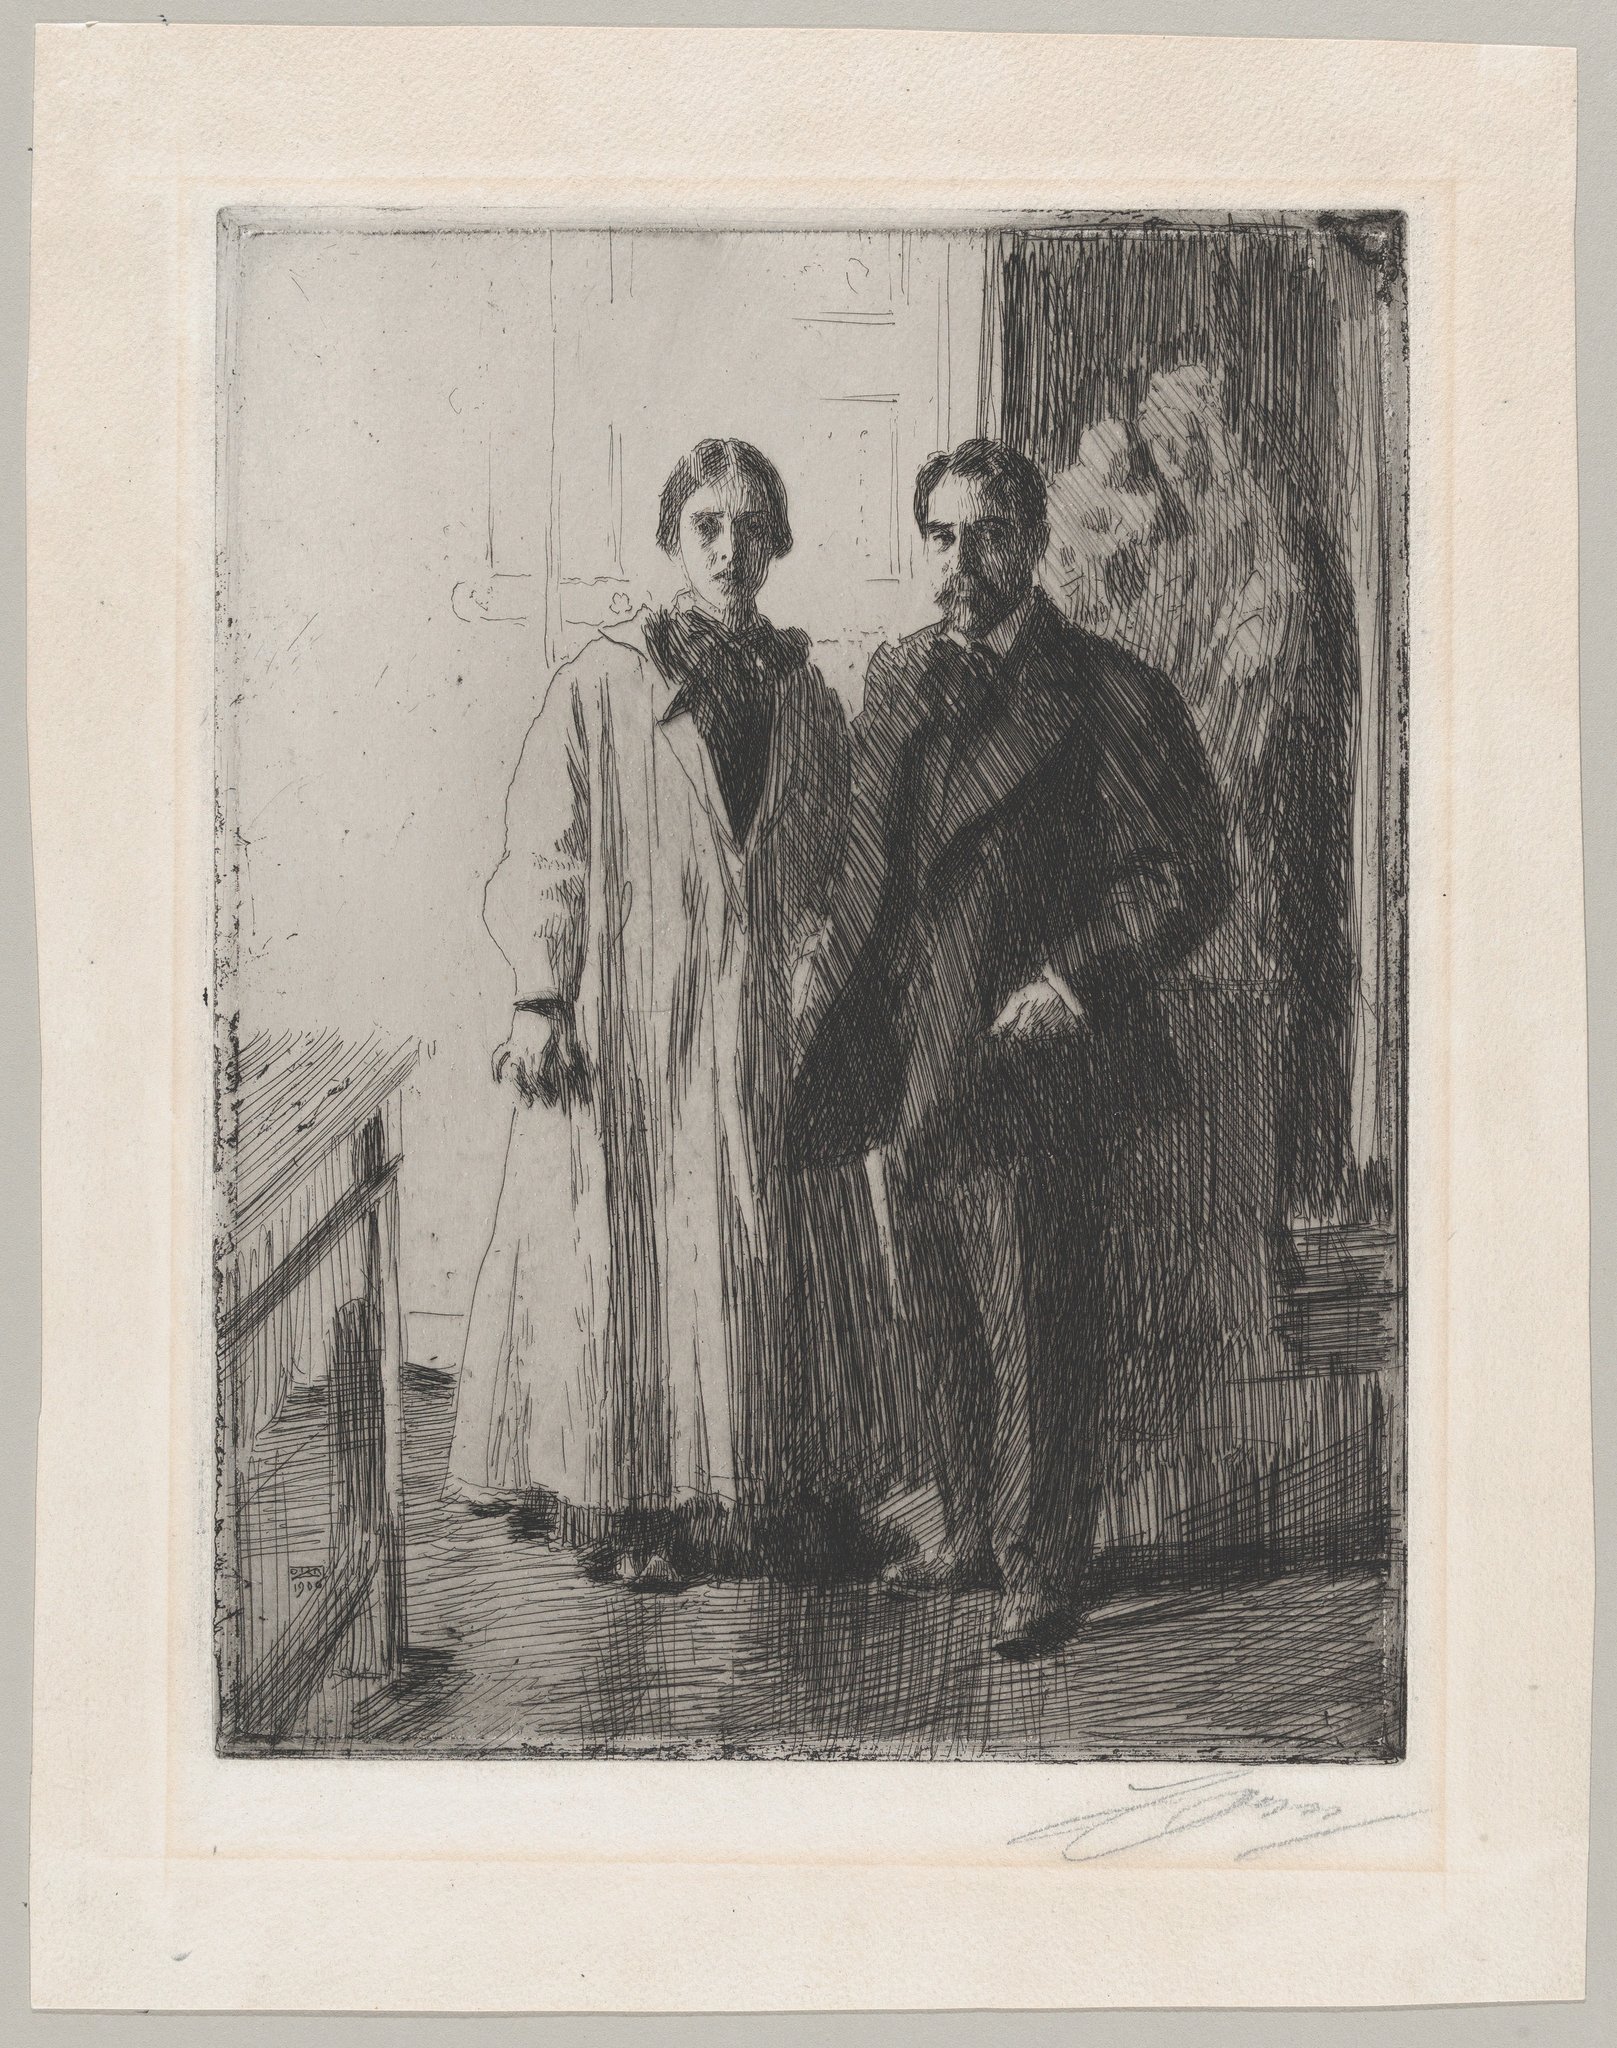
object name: print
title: Mr. and Mrs. Atherton Curtis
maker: anders zorn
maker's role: artist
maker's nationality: swedish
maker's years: 1860-1920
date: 1906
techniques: etching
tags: couples,men,women